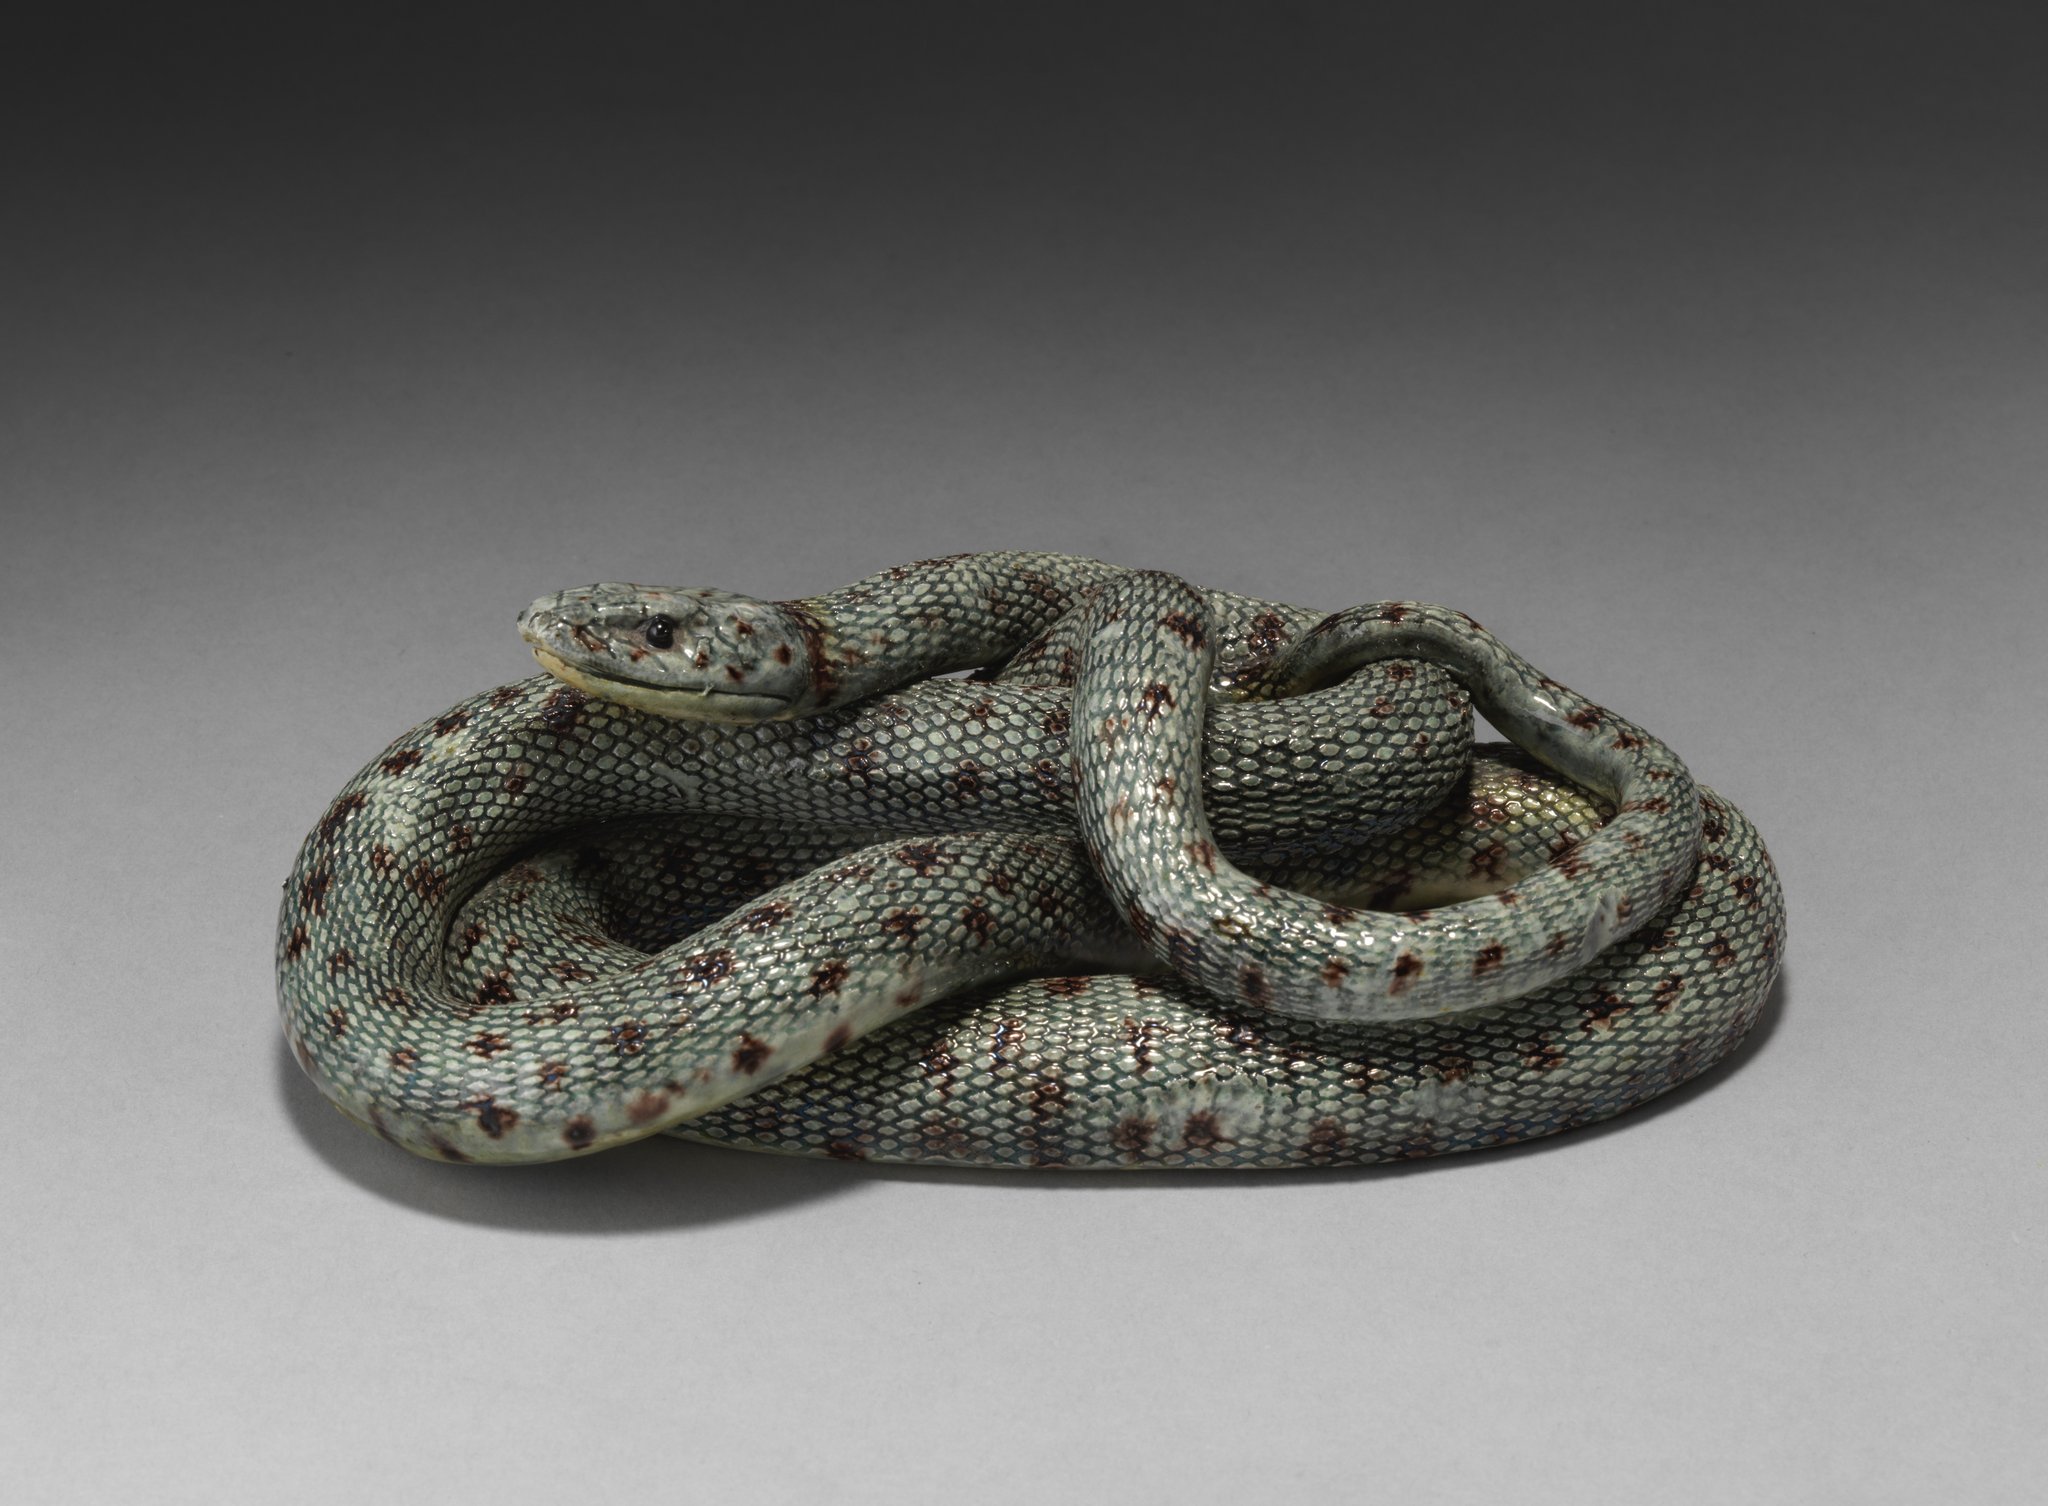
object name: figure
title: Snake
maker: saint-honoré-les-bains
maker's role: manufactory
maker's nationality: french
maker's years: 1820-1914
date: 1870-1880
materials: earthenware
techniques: glazing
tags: snakes